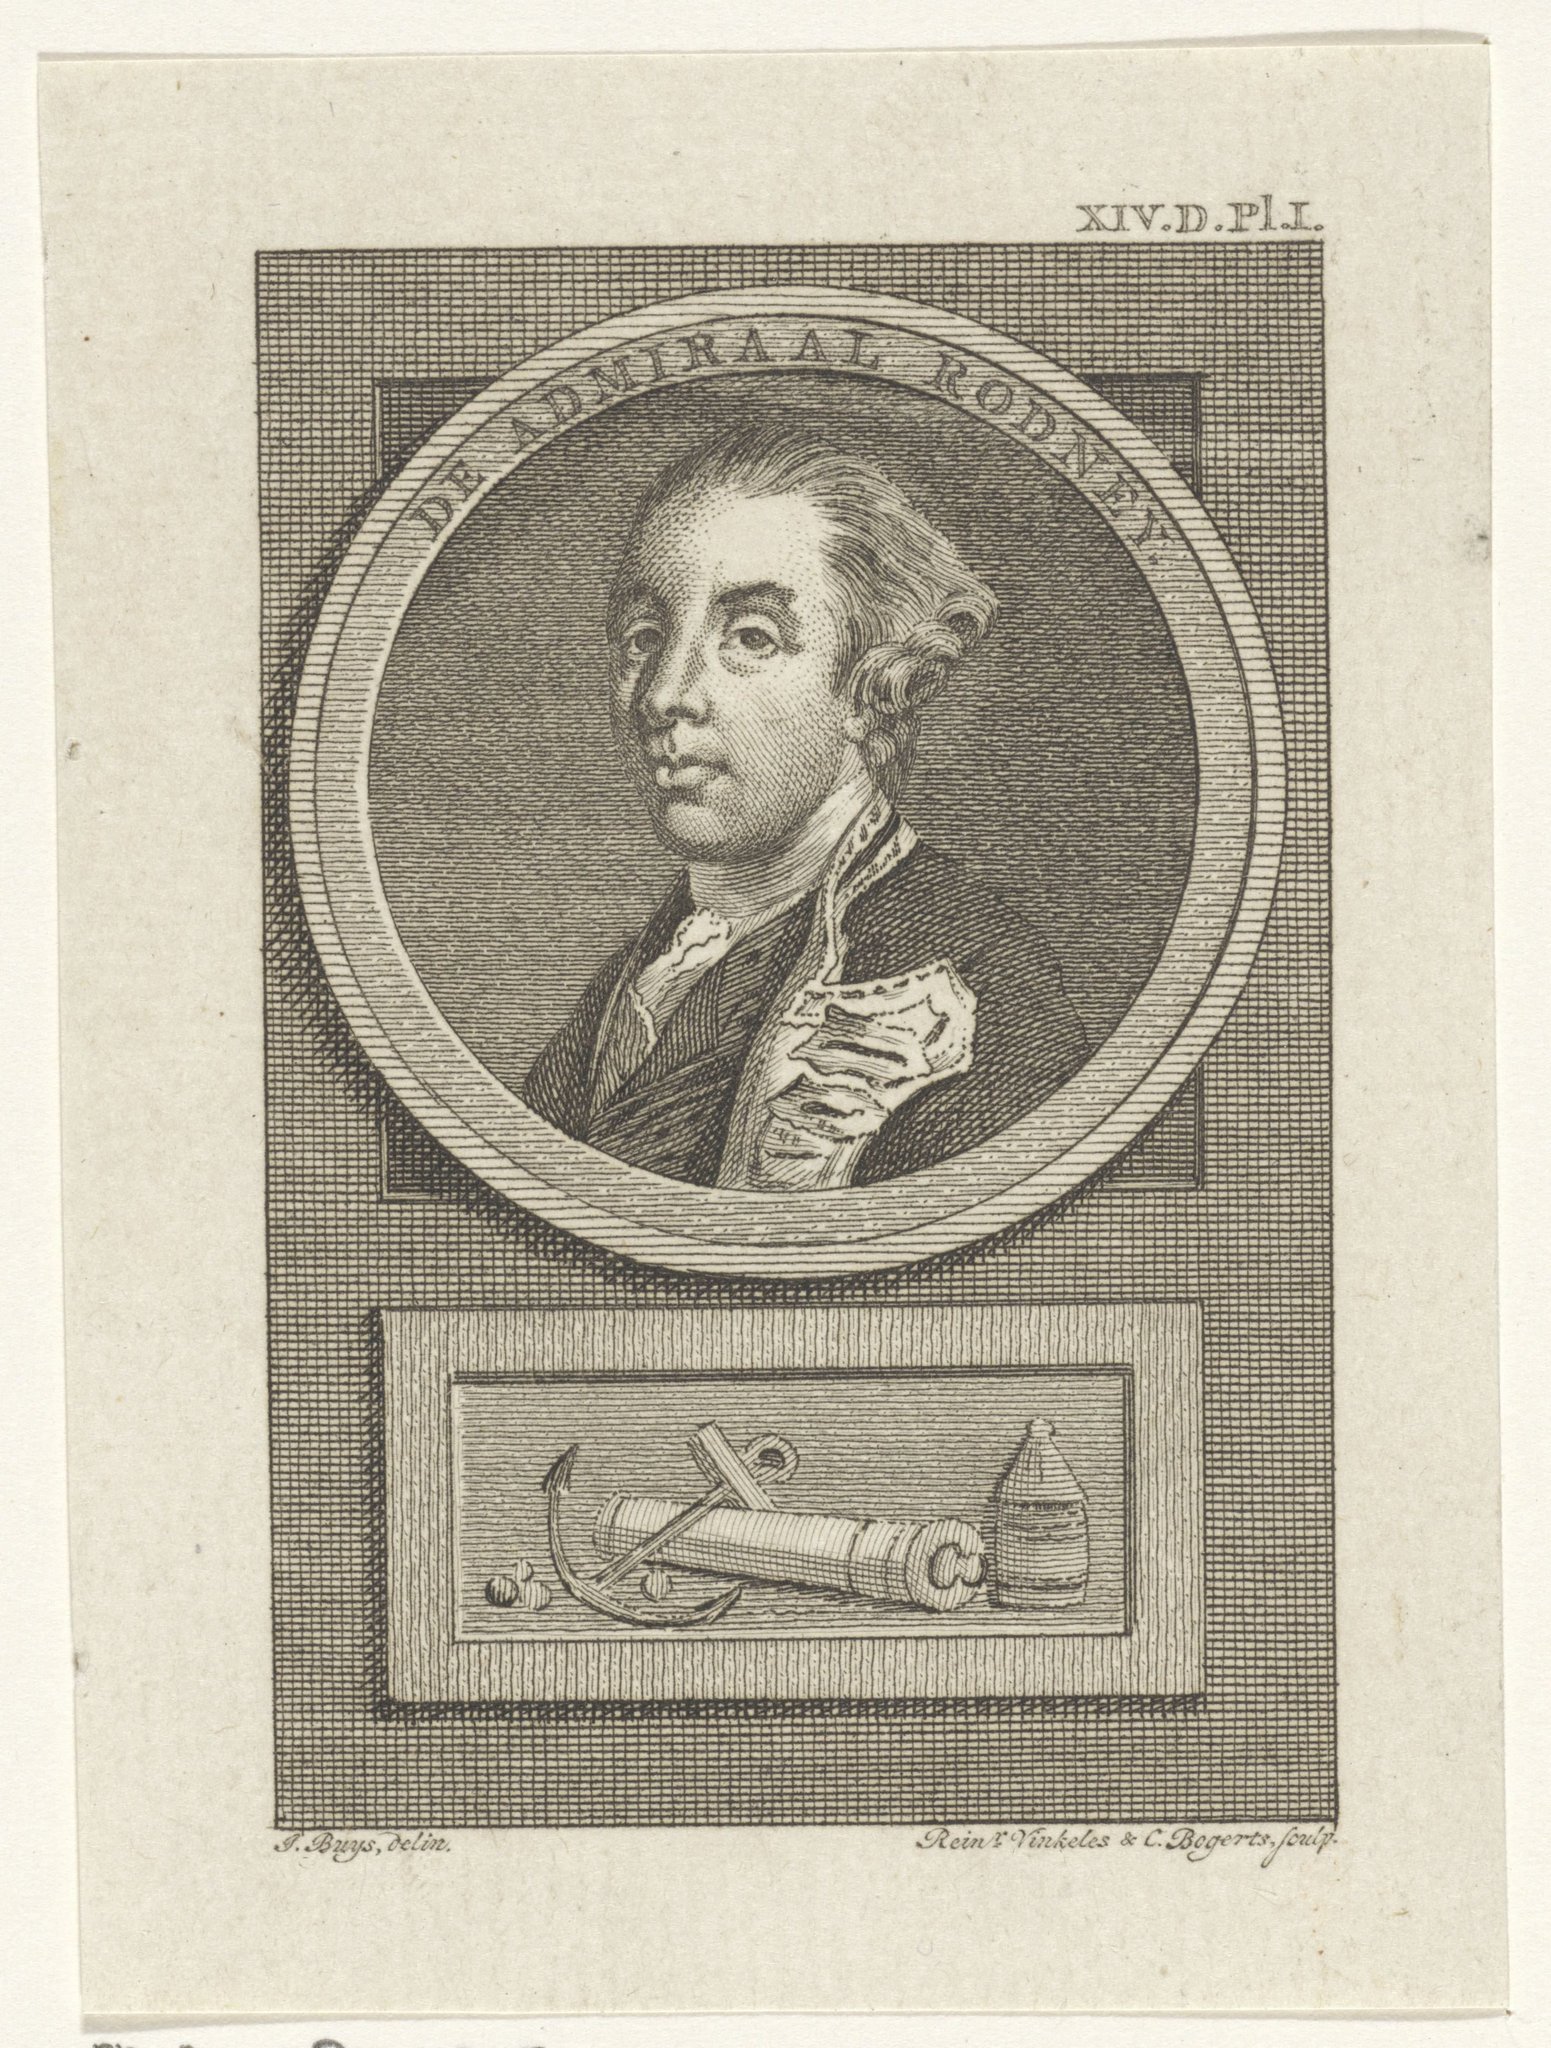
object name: book illustration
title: Portret van George Brydges, baron Rodney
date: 1783-1795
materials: paper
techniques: engraving, etching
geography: amsterdam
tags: wooden container: barrel, cask, bucket, firearms: cannon, parts of ship's exterior: anchor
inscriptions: collector's mark: Lugt 2228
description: Prent gebruikt in: Fokke, Jan. Geschiedenissen der Vereenigde Nederlanden voor de vaderlandsche jeugd Ie-XXVste deel. Amsterdam: Johannes Allart, 1783-1795. Deel XIV.